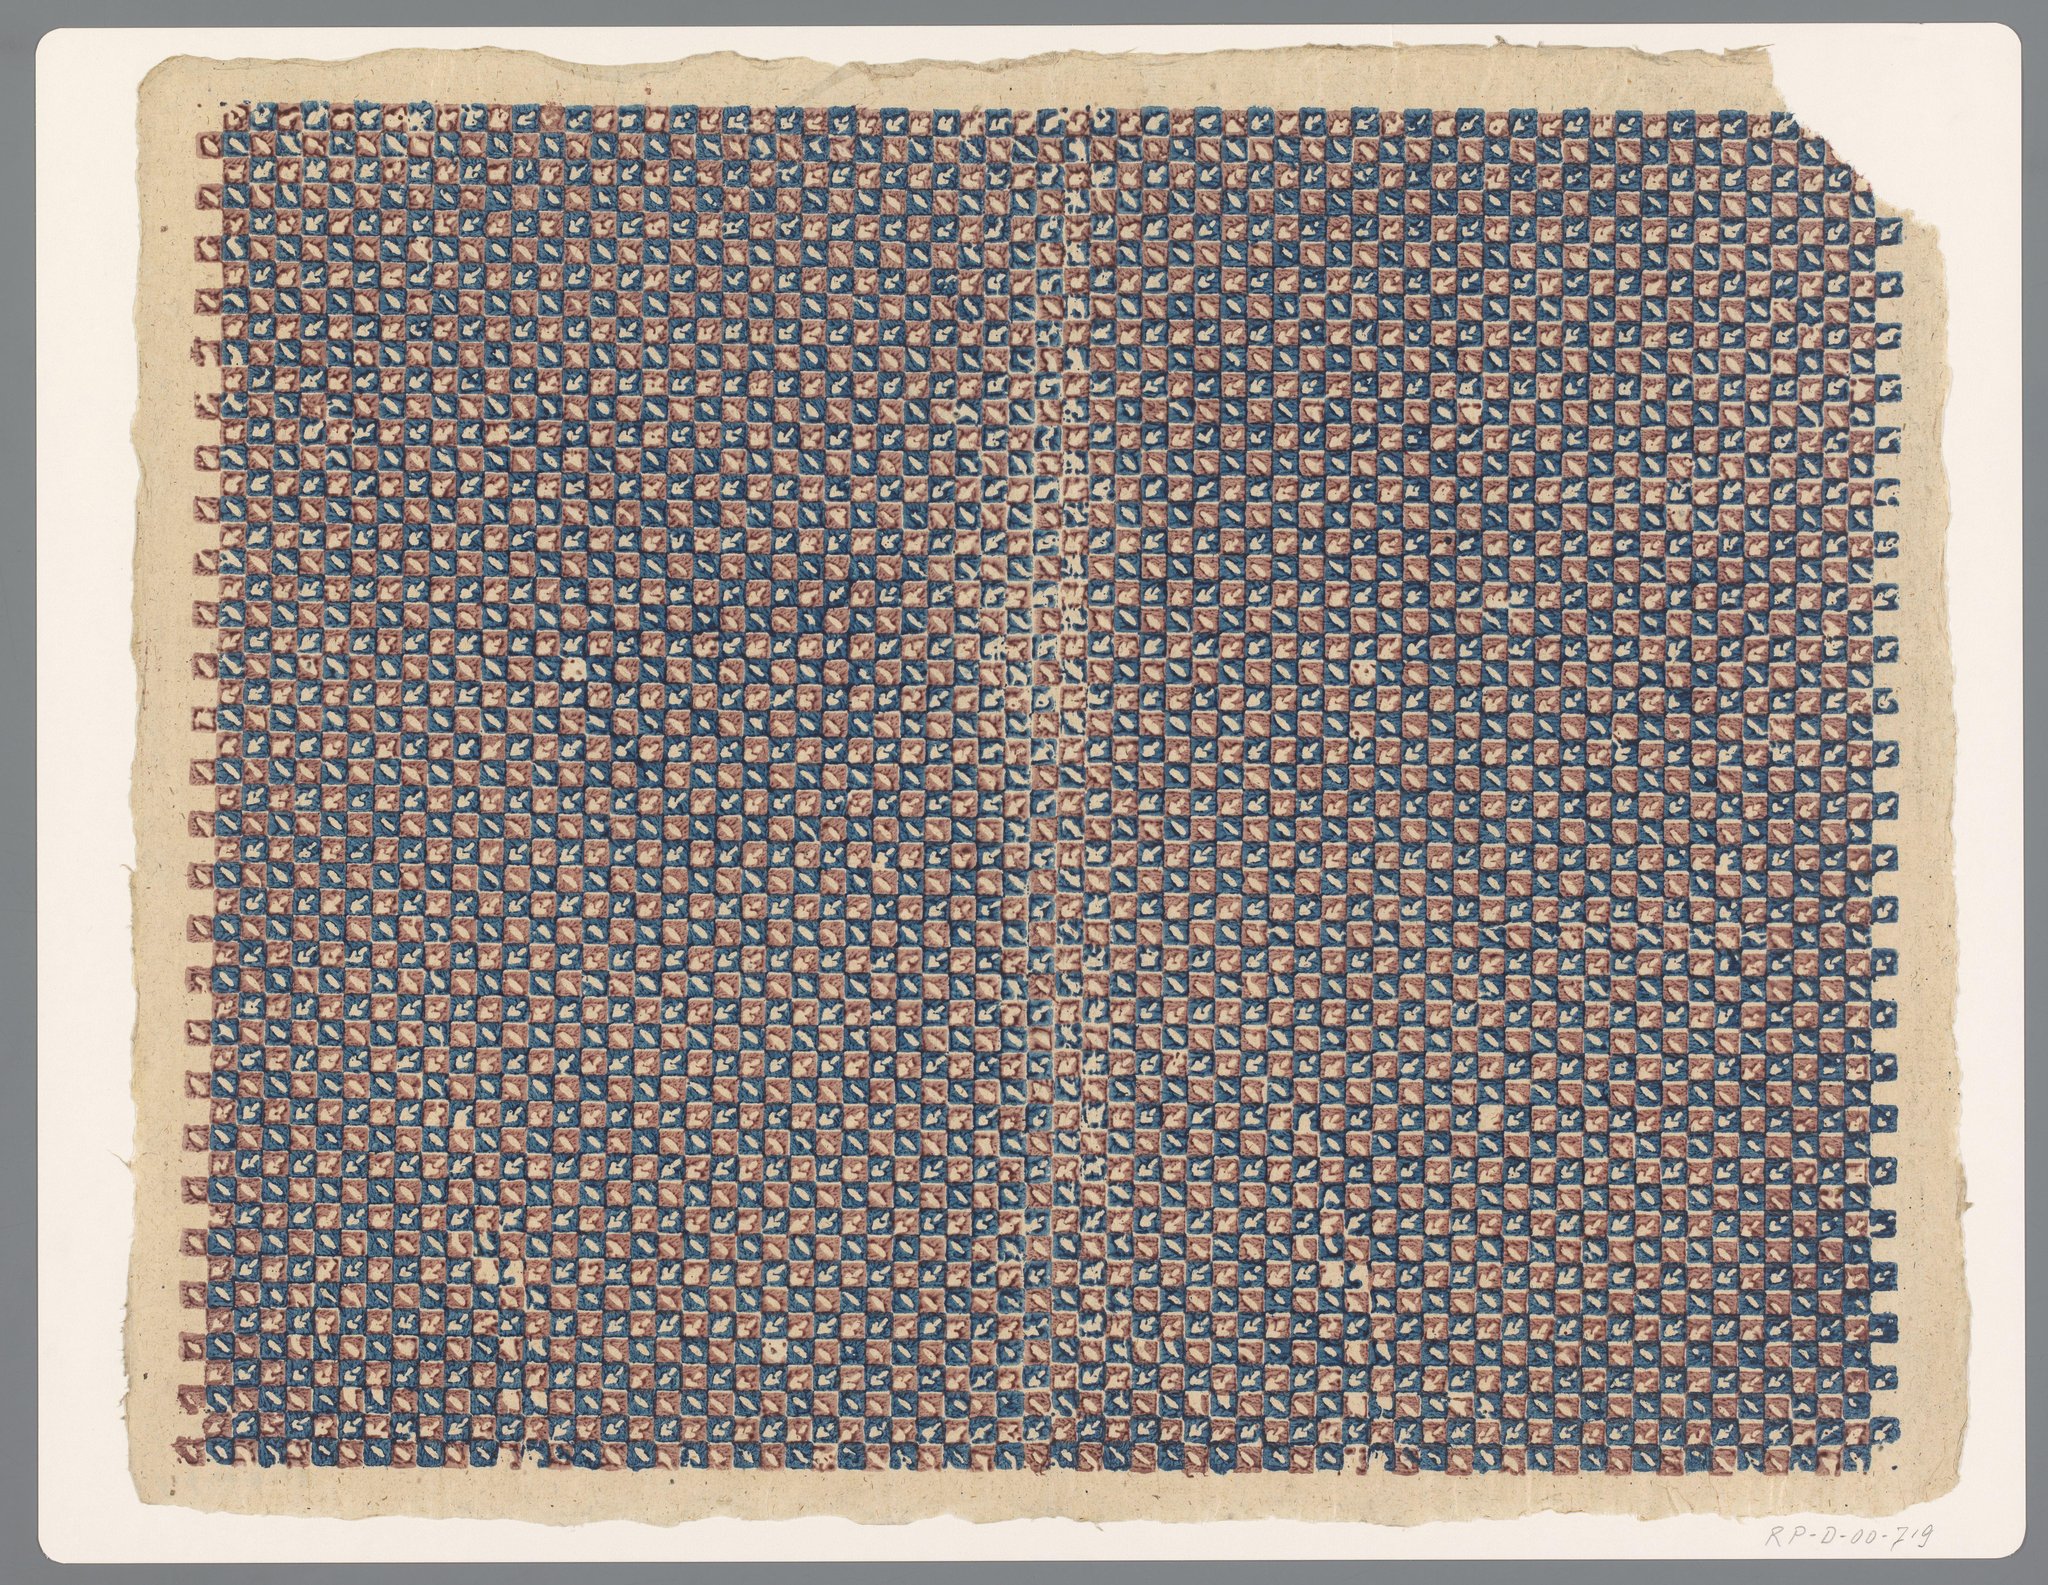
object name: printed paper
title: Blad met schaakbordpatroon met bladmotieven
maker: Anonymous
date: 1750-1900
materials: paper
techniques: printing block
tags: ornament ~ geometric motifs, ornament derived from plant forms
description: Blad met schaakbordpatroon met bladmotieven.